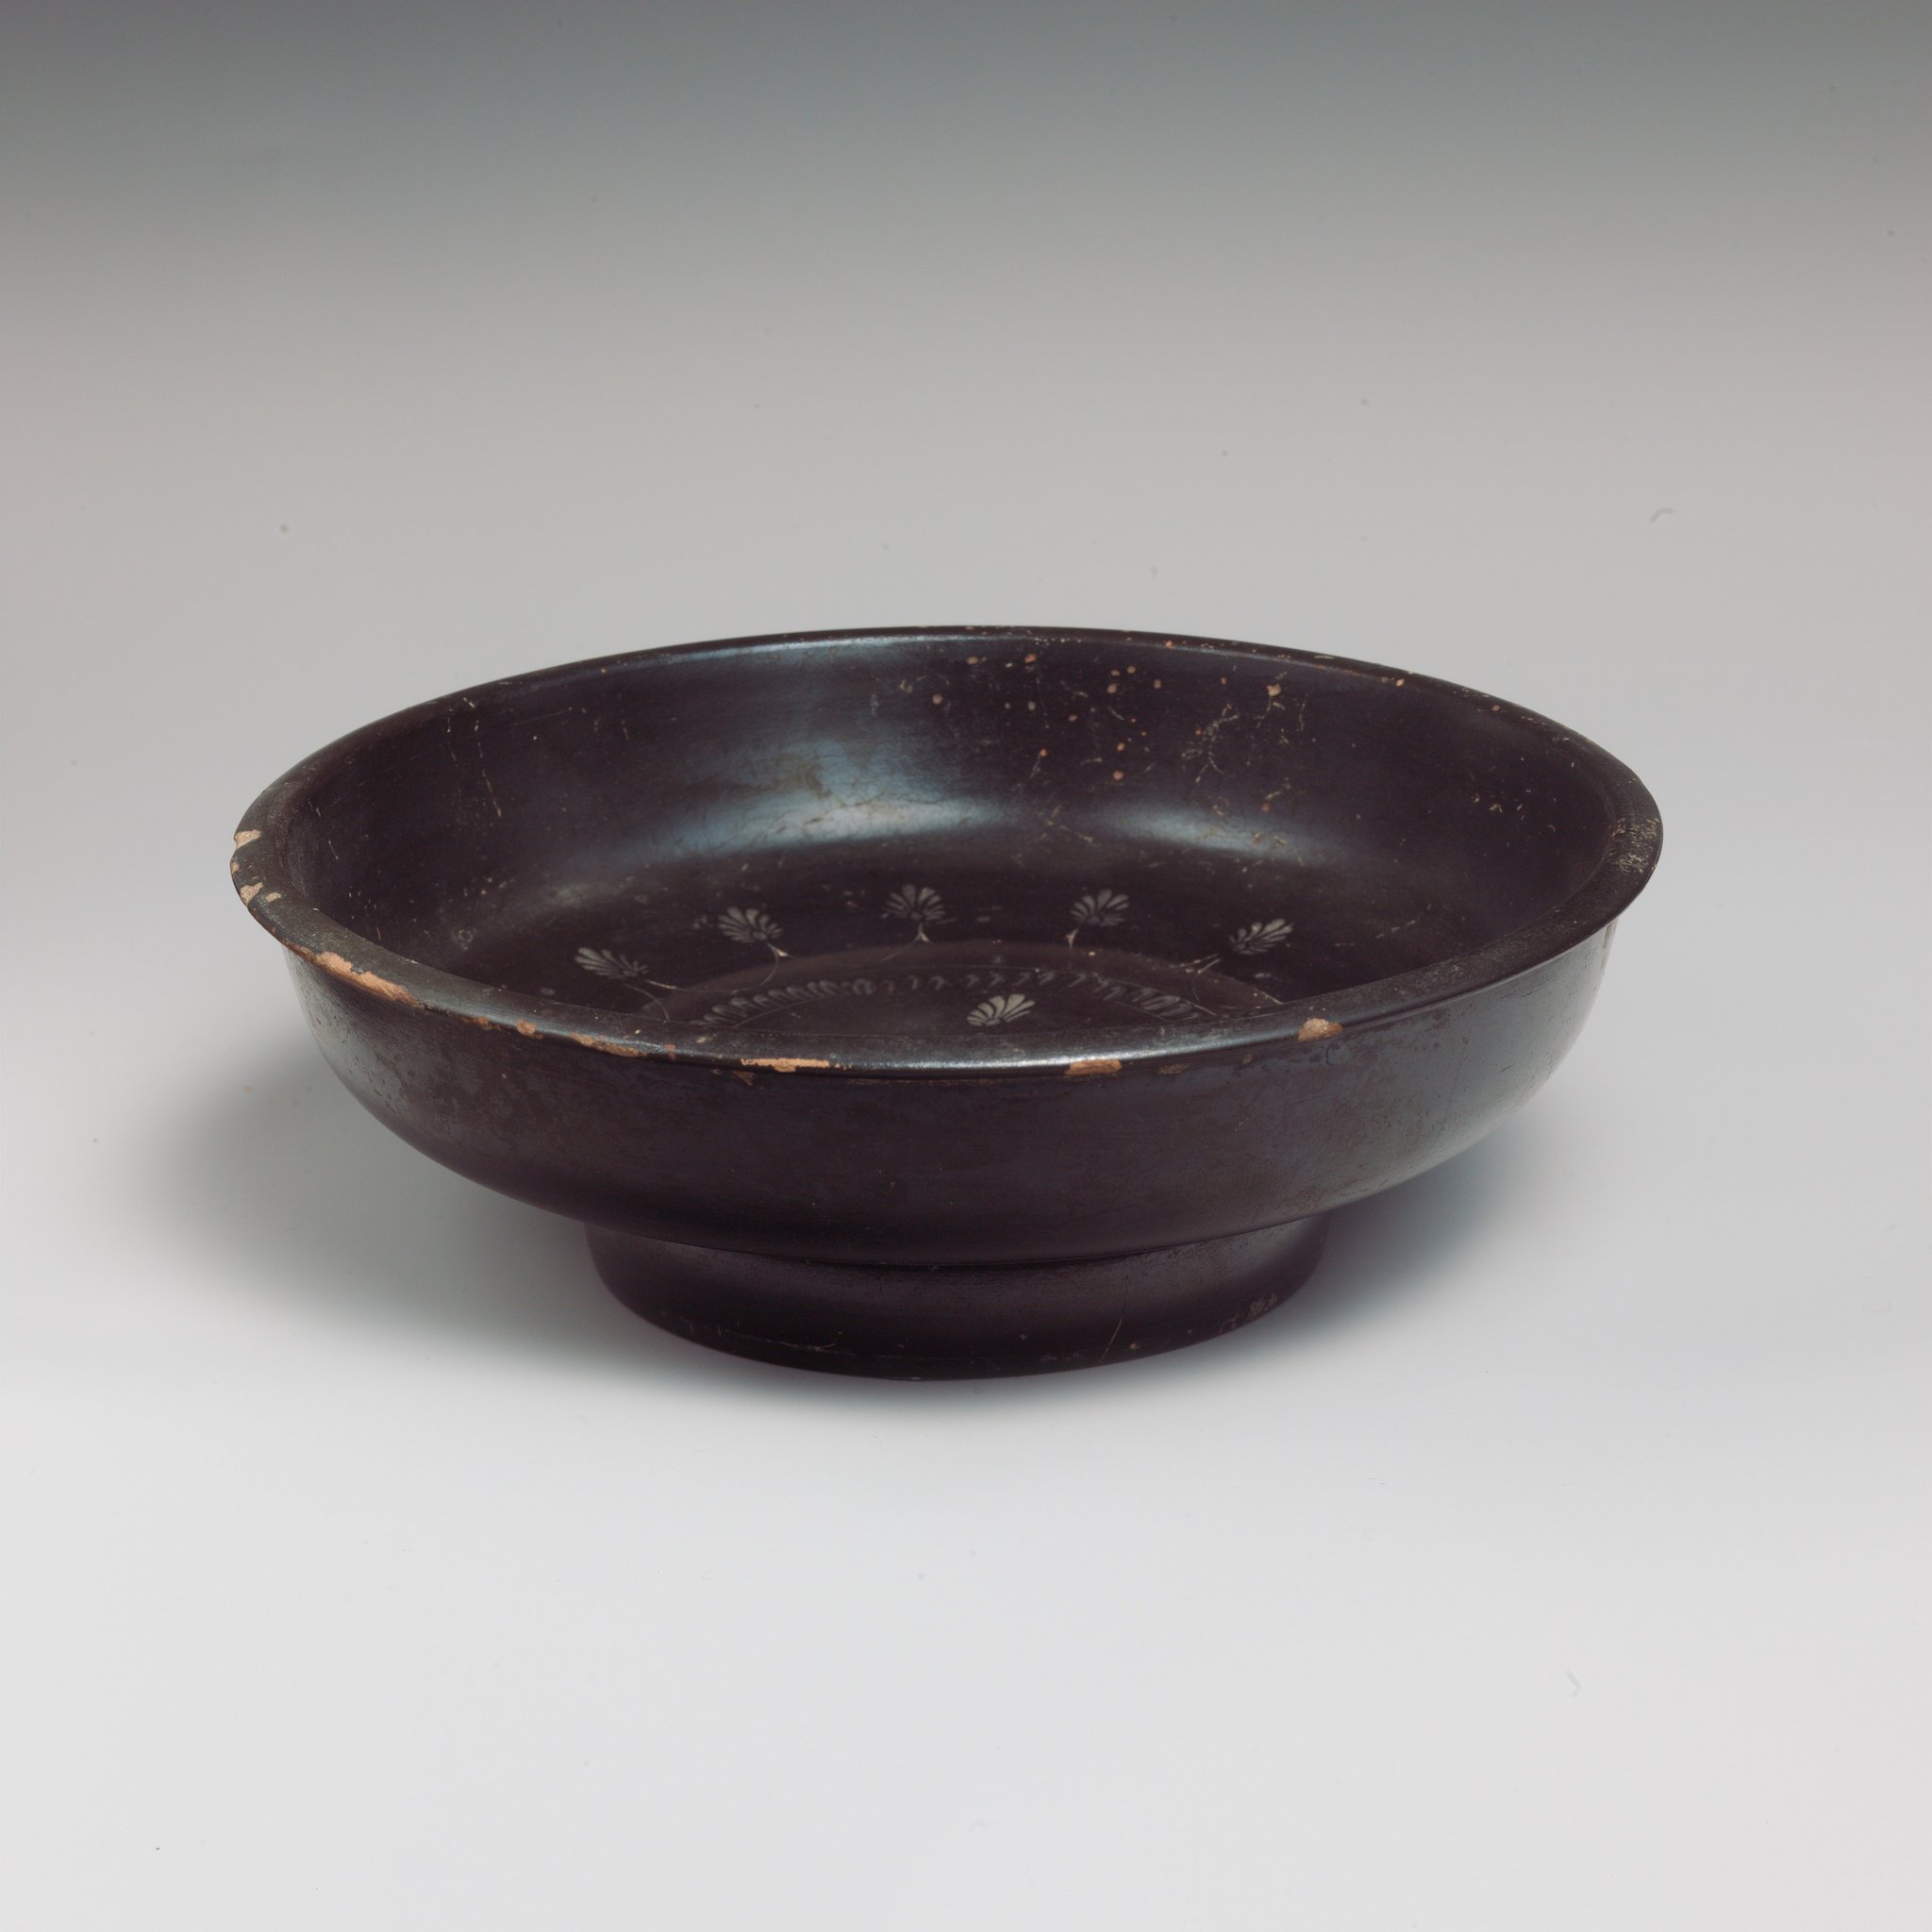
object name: bowl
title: Terracotta bowl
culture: greek or south italian or campanian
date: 400-301 BCE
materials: terracotta